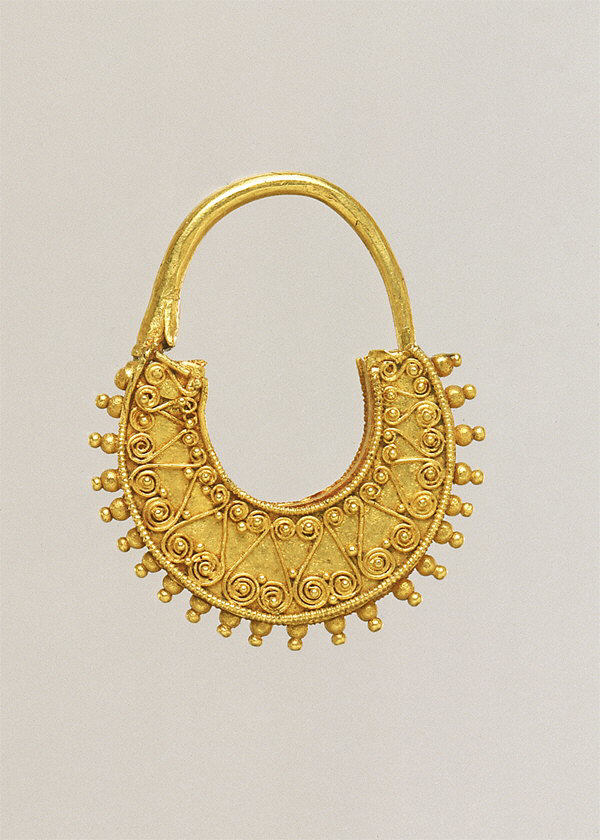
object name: earring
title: Gold crescent-shaped earring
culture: greek, cypriot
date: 450-401 BCE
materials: gold